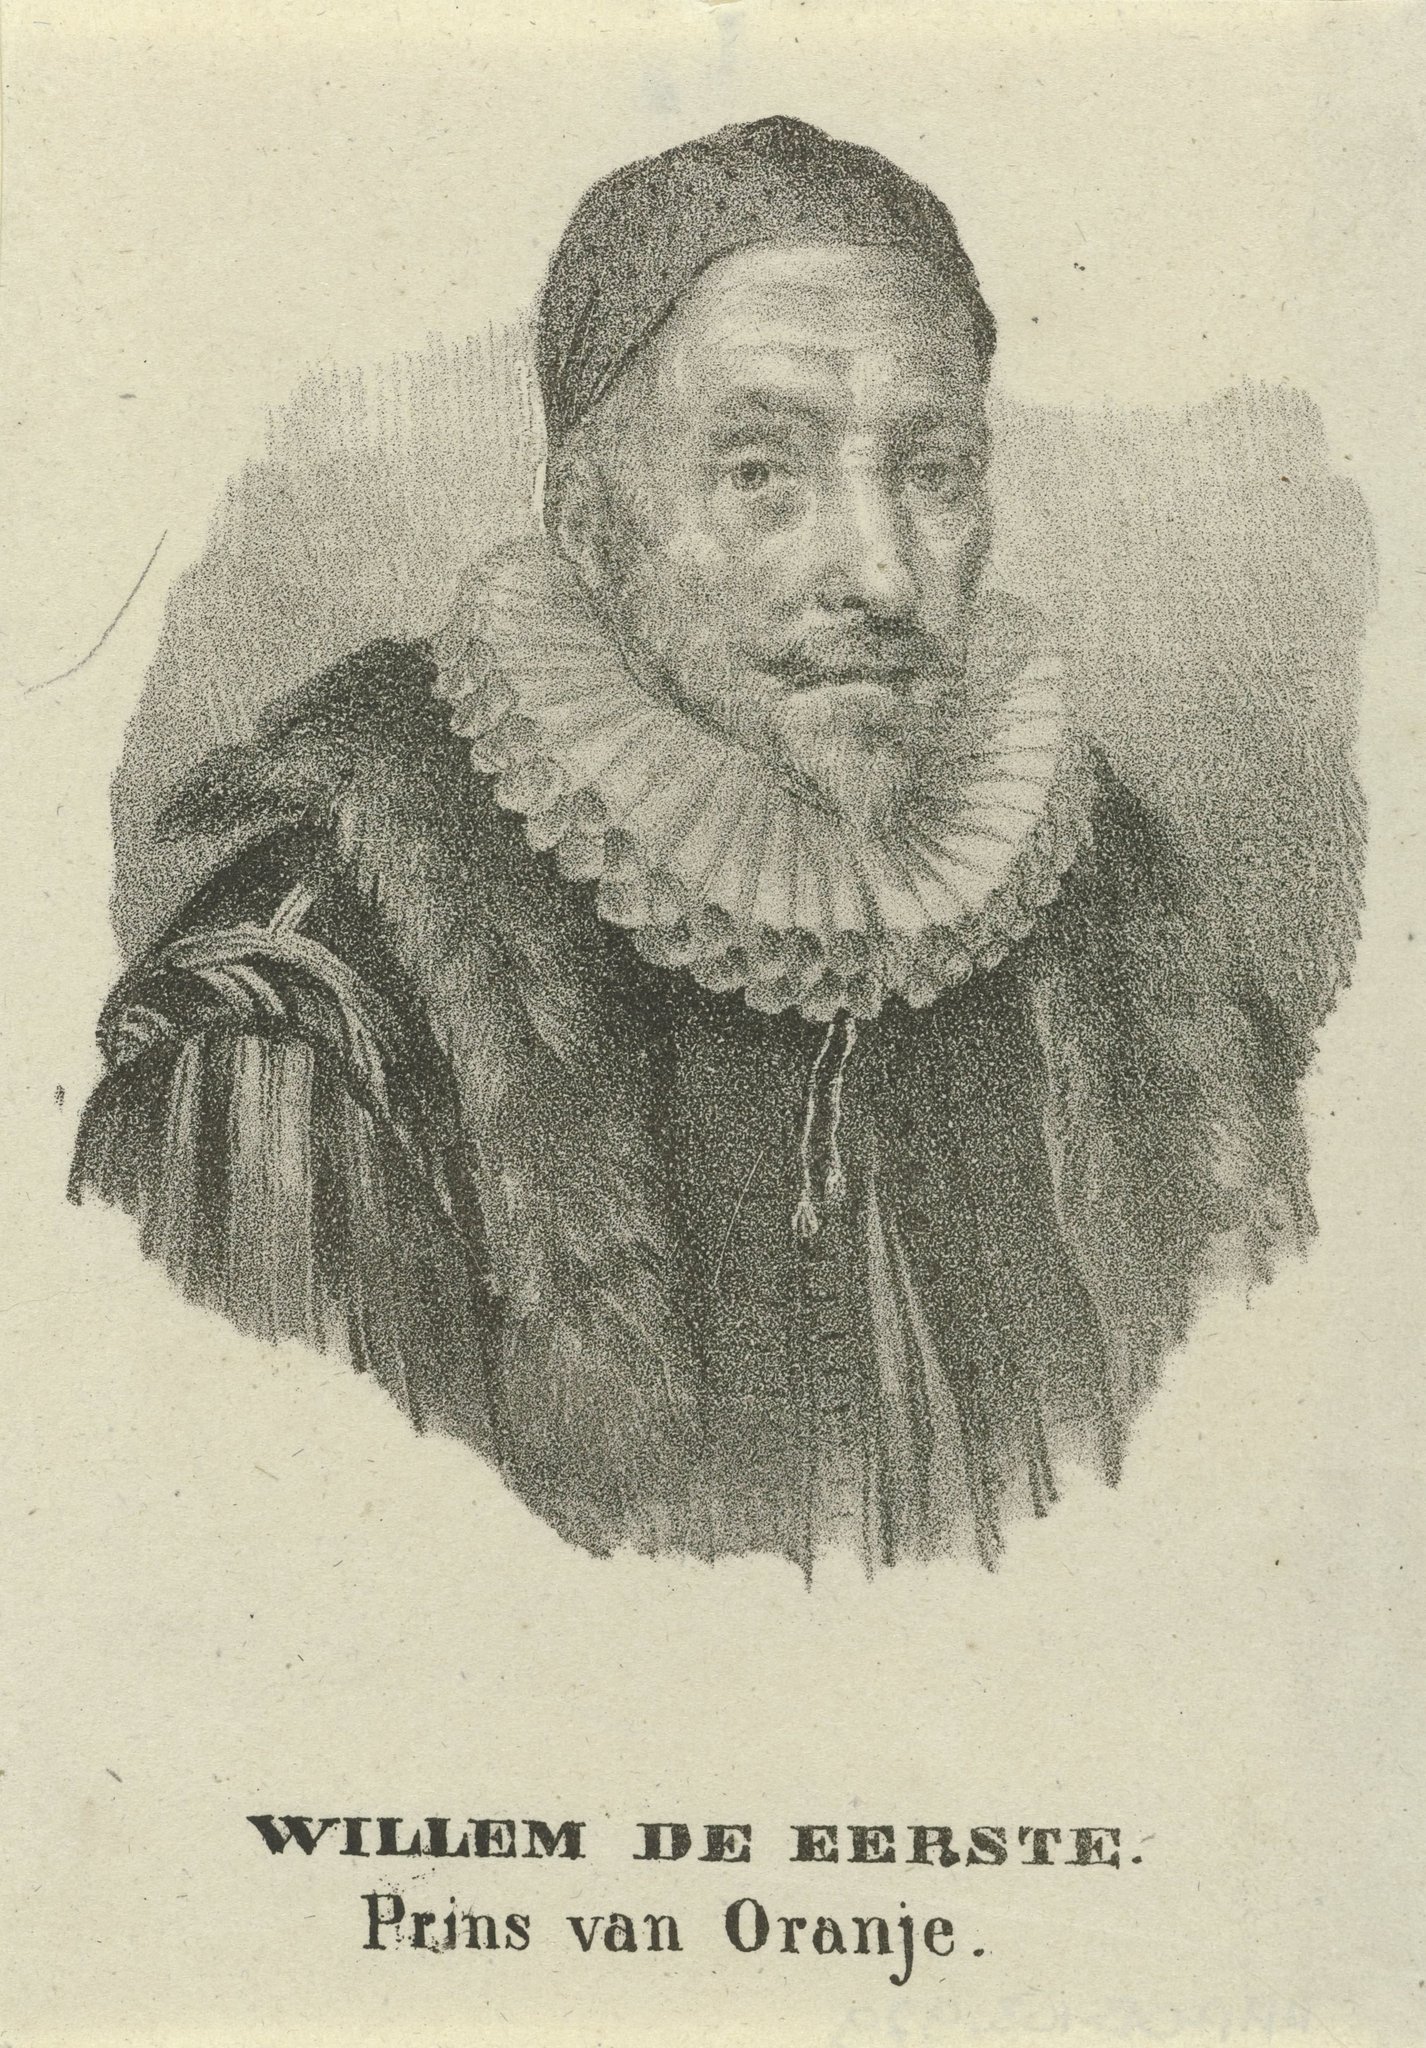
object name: print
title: Portret van Willem I, prins van Oranje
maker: Anonymous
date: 1800-1899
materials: paper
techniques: lithograph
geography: low countries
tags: delft, william i (prince of orange)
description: De hier vermelde titel verwijst naar de hoogst verkregen titel van de geportretteerde, niet per se naar de titel die de geportretteerde op deze voorstelling draagt.